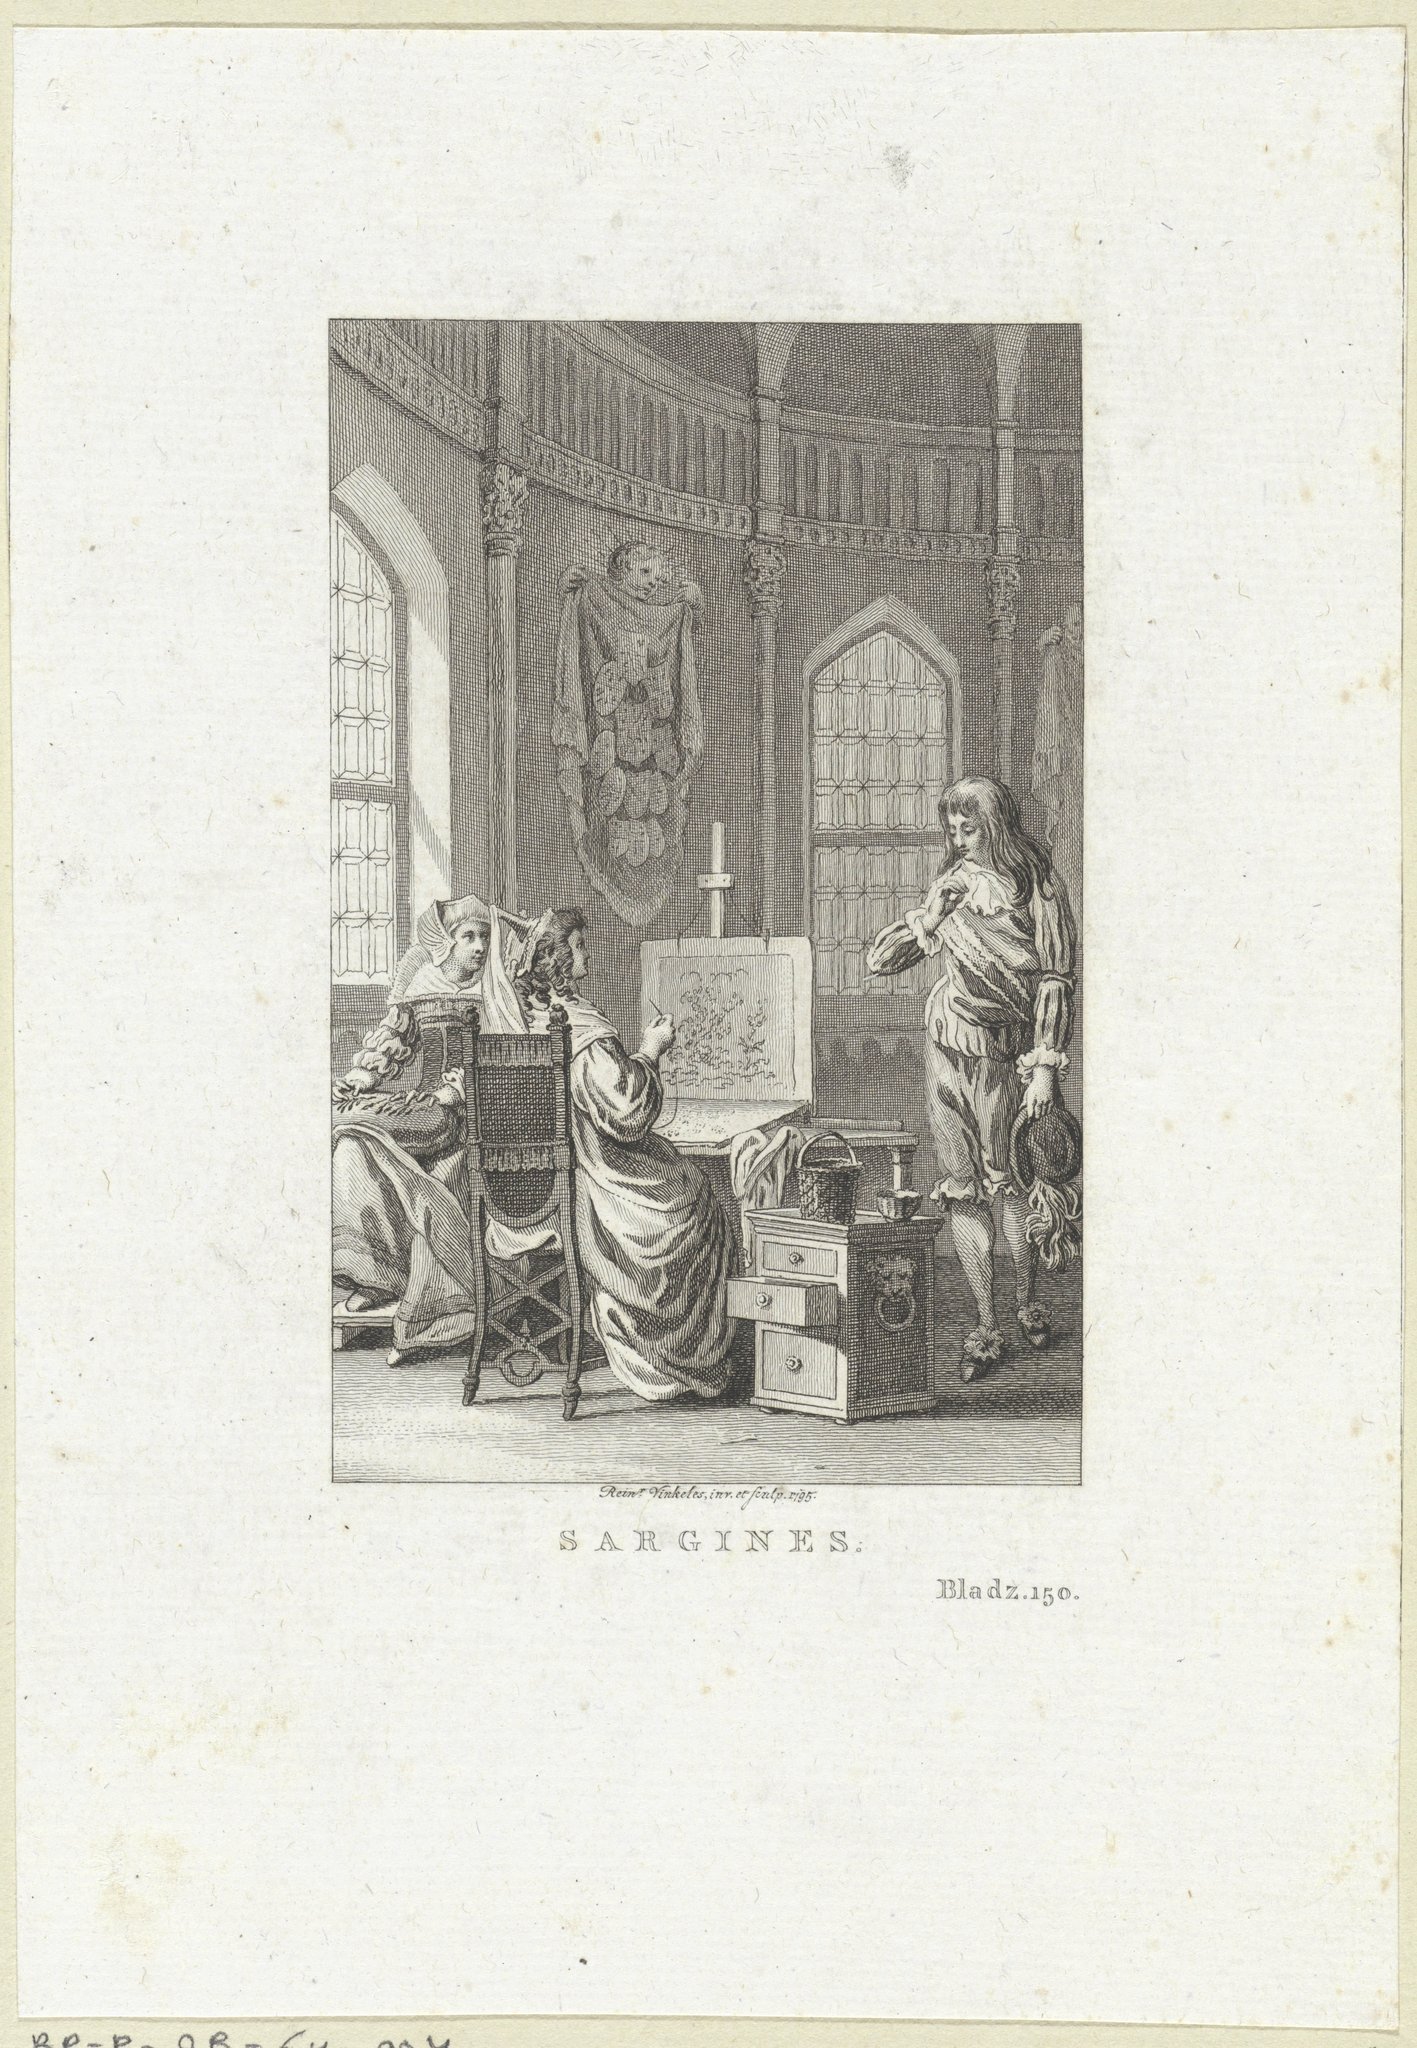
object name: print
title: Twee handwerkende dames in gesprek met een heer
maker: reinier vinkeles (i)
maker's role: draughtsman, print maker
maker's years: 1741-1816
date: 1795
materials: paper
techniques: engraving, etching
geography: amsterdam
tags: conversation, dialogue; conversation piece, sewing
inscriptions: collector's mark: Lugt 240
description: Illustratie bij het verhaal 'Sargines' in: Baculard d'Arnaud, François Thomas Marie de. Zedelyke verhaalen, deel 14. Amsterdam: Erven van Pieter Meyer en Gerrit Warnars, 1795.